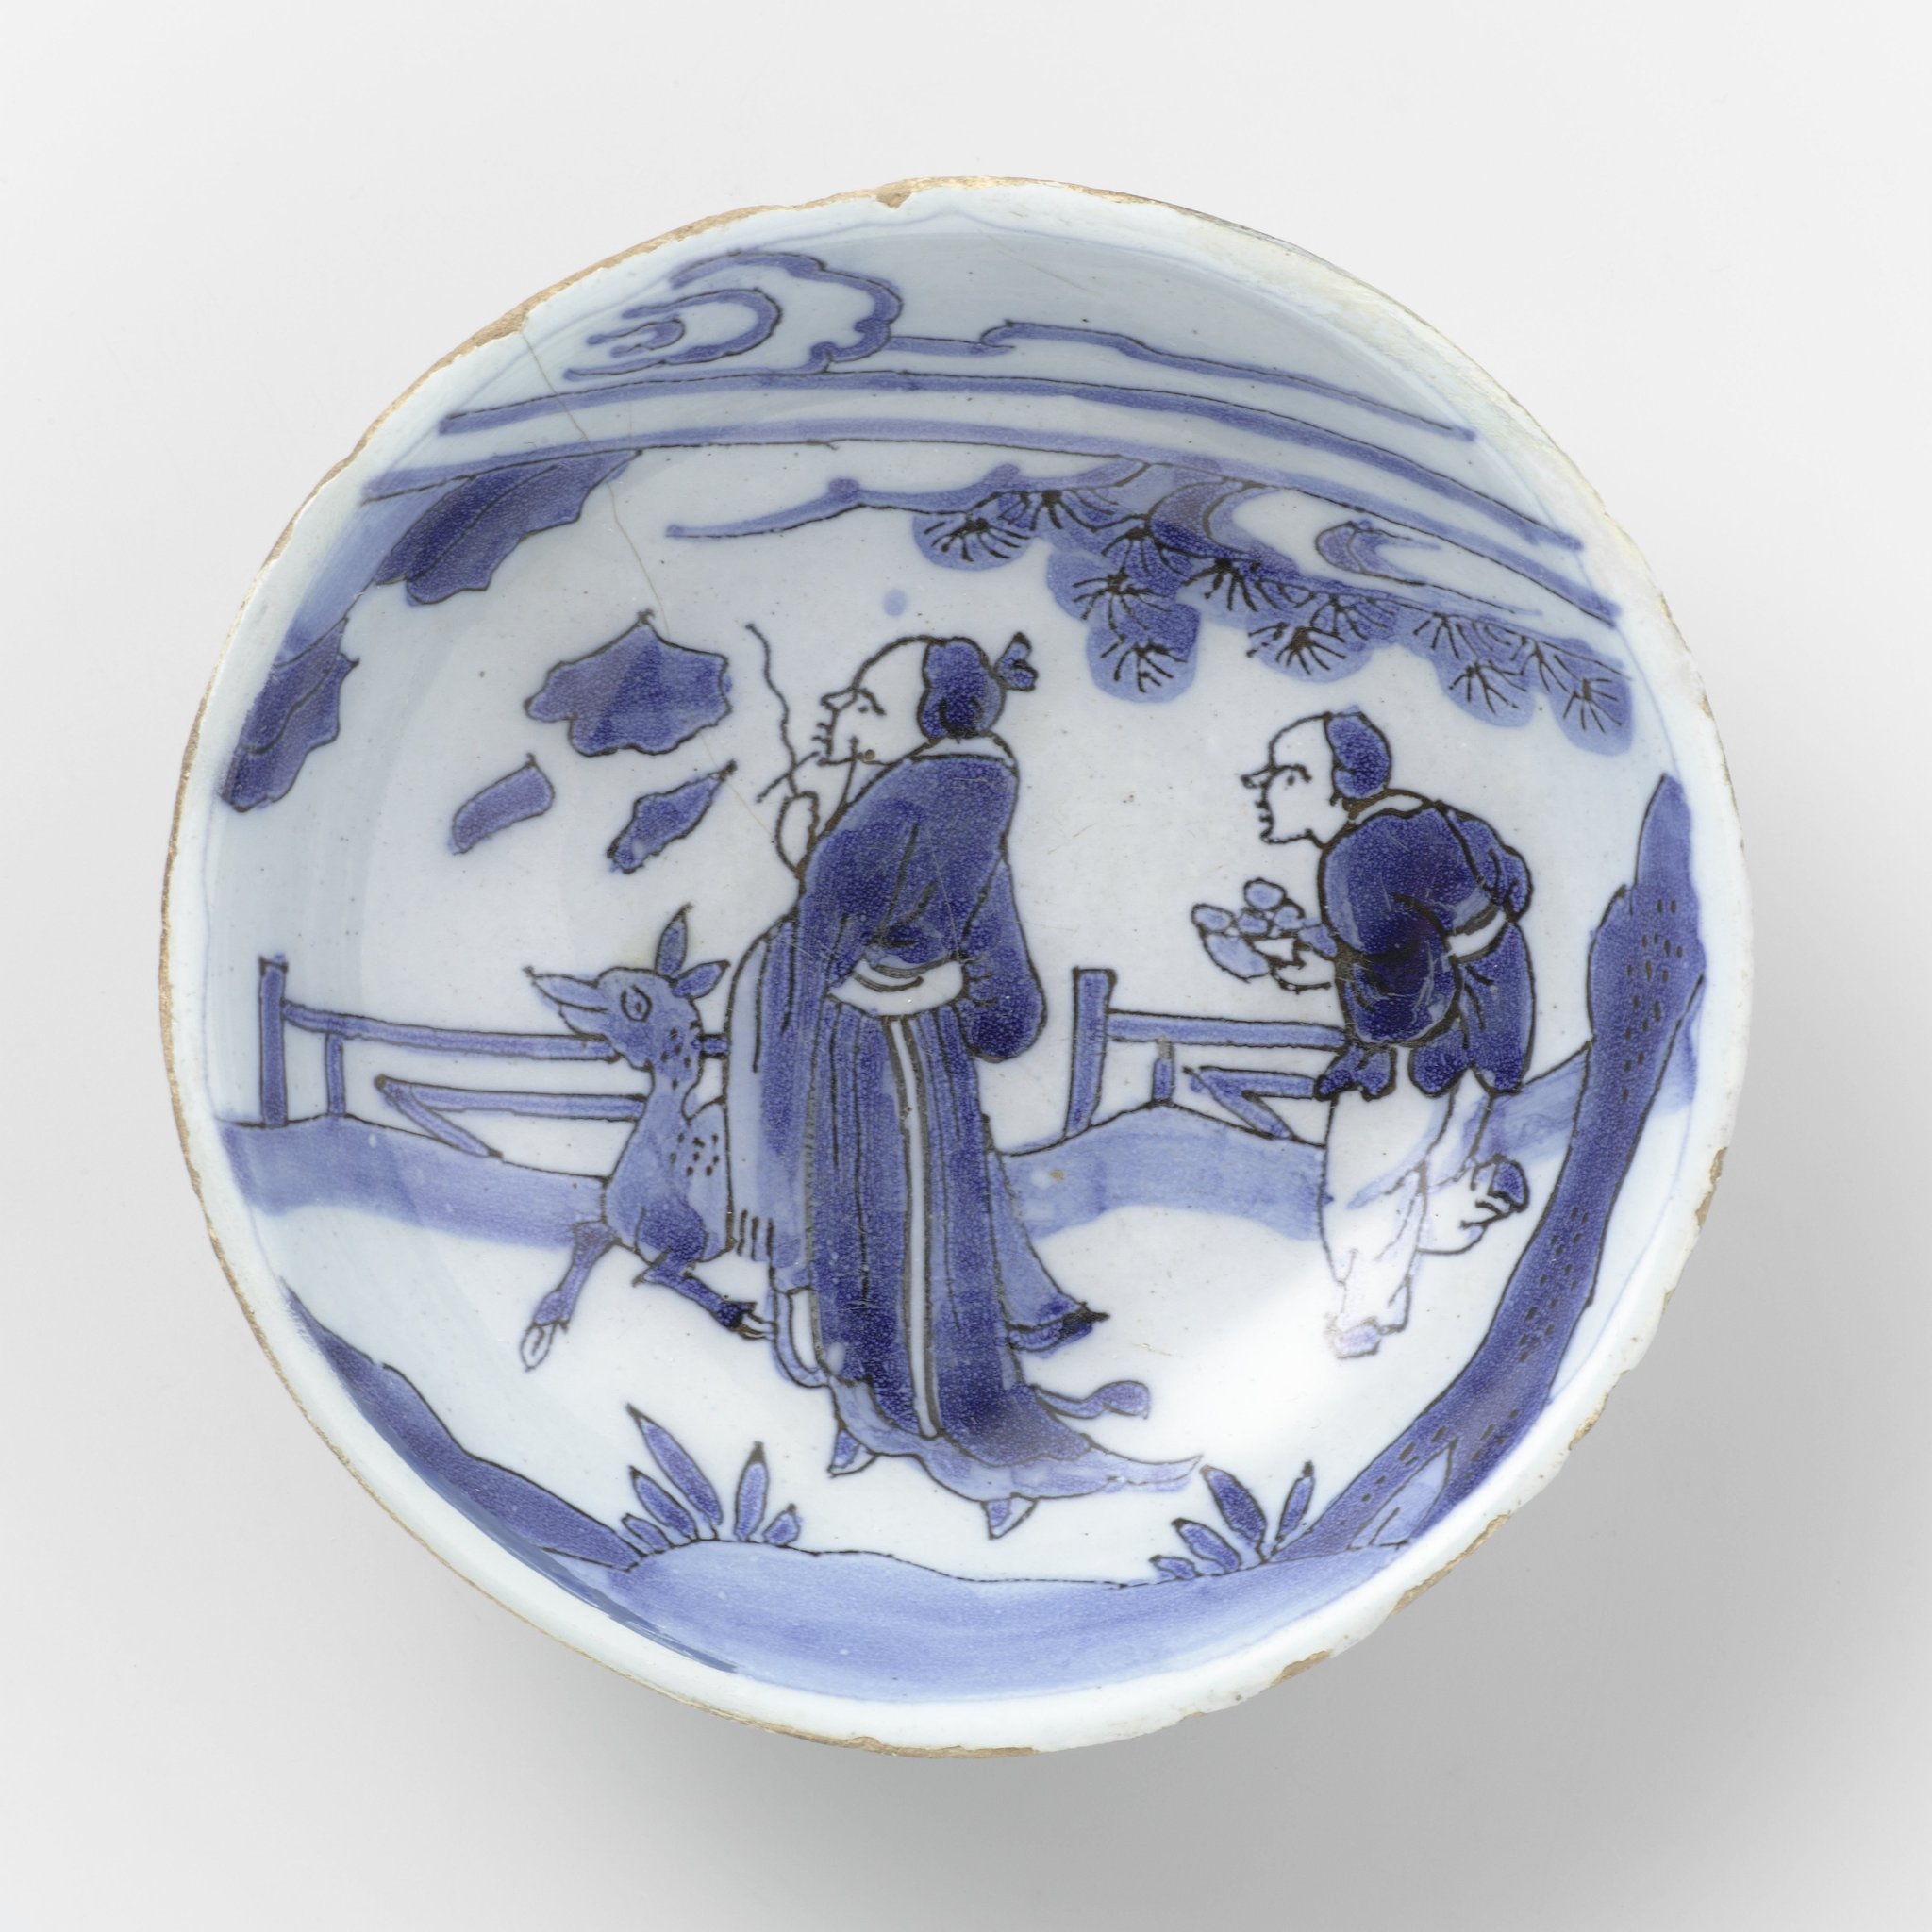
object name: container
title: Bakje van faience met een chinoiserie decoratie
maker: rochus jacobsz. hoppesteijn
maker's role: plateelbakker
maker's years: -1692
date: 1670-1690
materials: faience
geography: delft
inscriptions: mark: ‘RIHS(ineen)/ 12’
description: Rond bakje op lage voet van aardewerk met wit tinglazuur bedekt. Beschilderd in blauw met twee Chinezen en een hert in een tuin met hekjes.